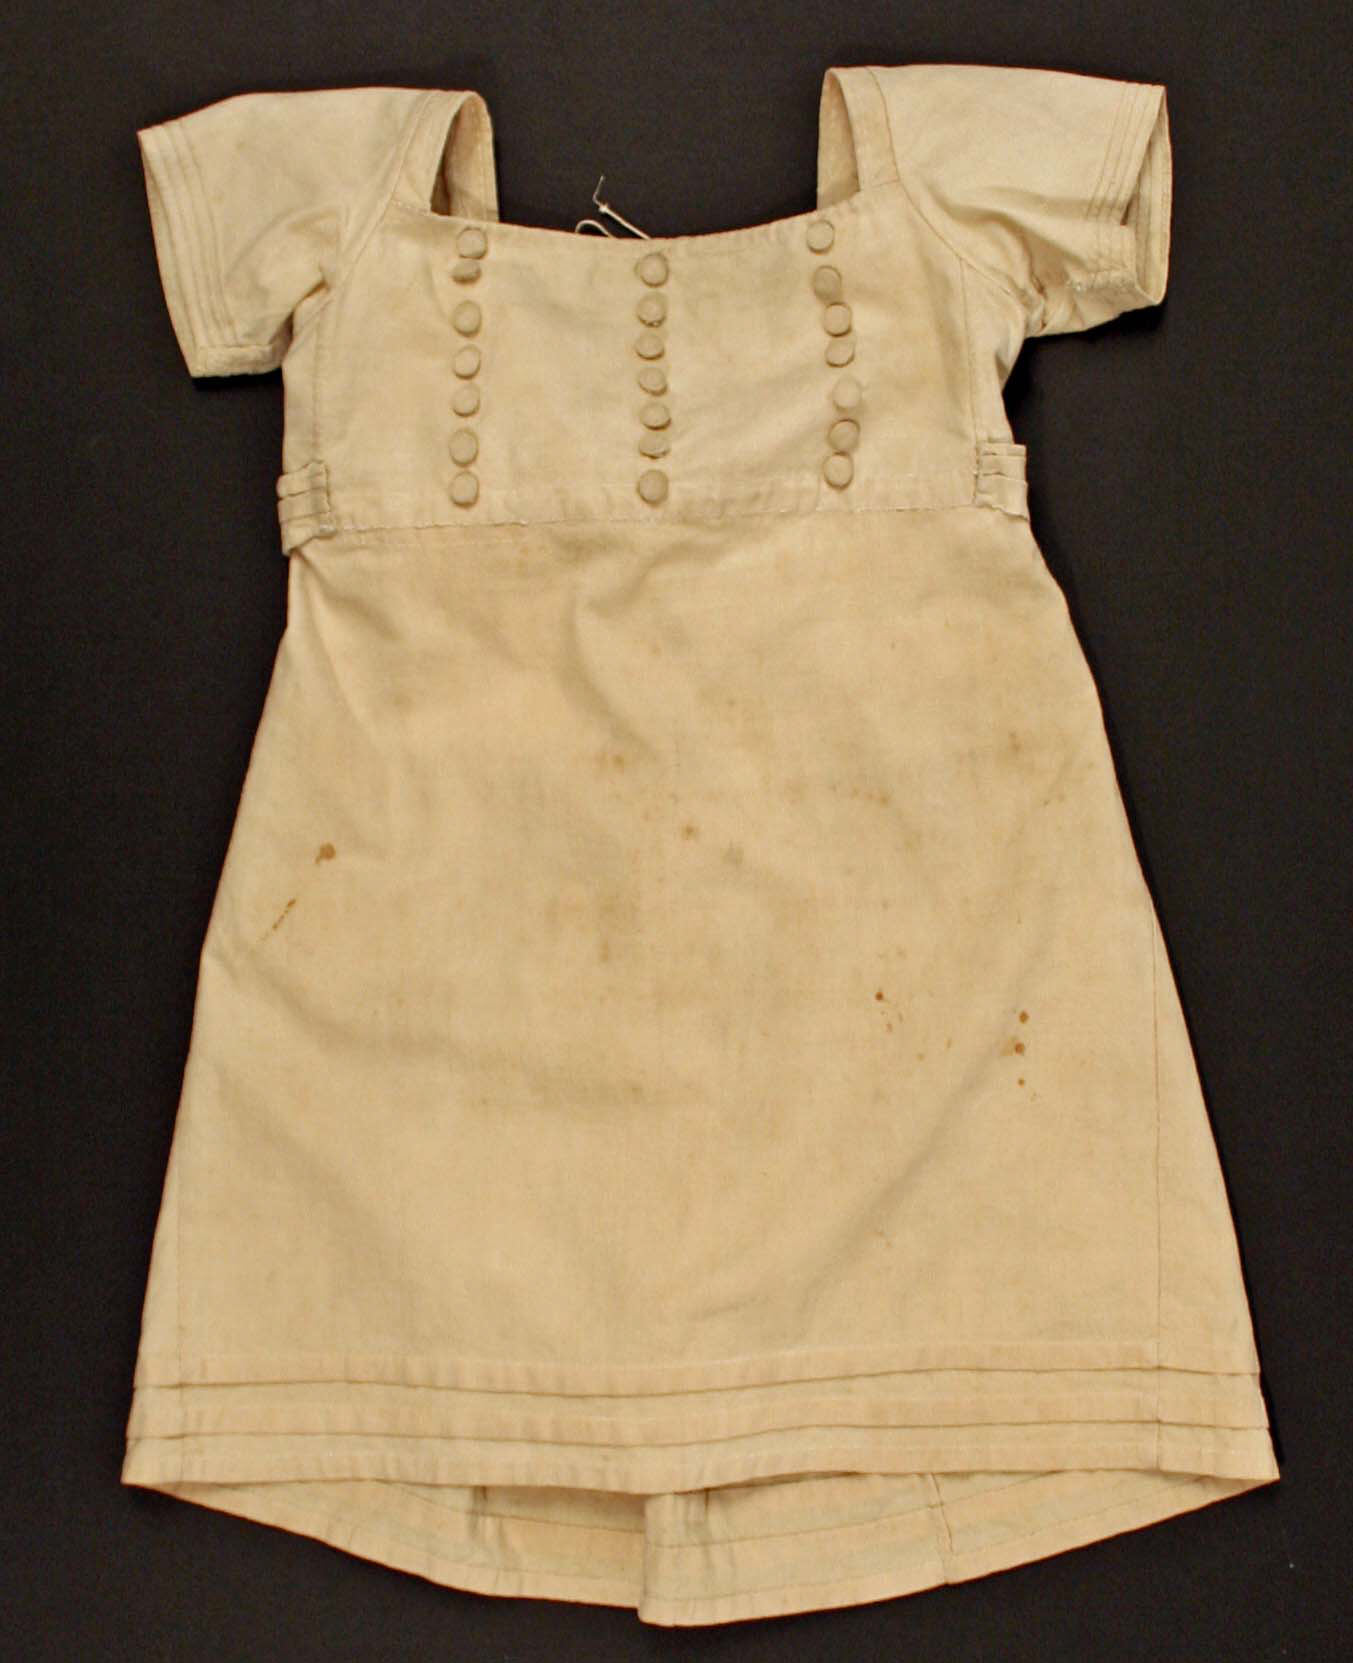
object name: suit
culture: british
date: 1815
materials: cotton, linen